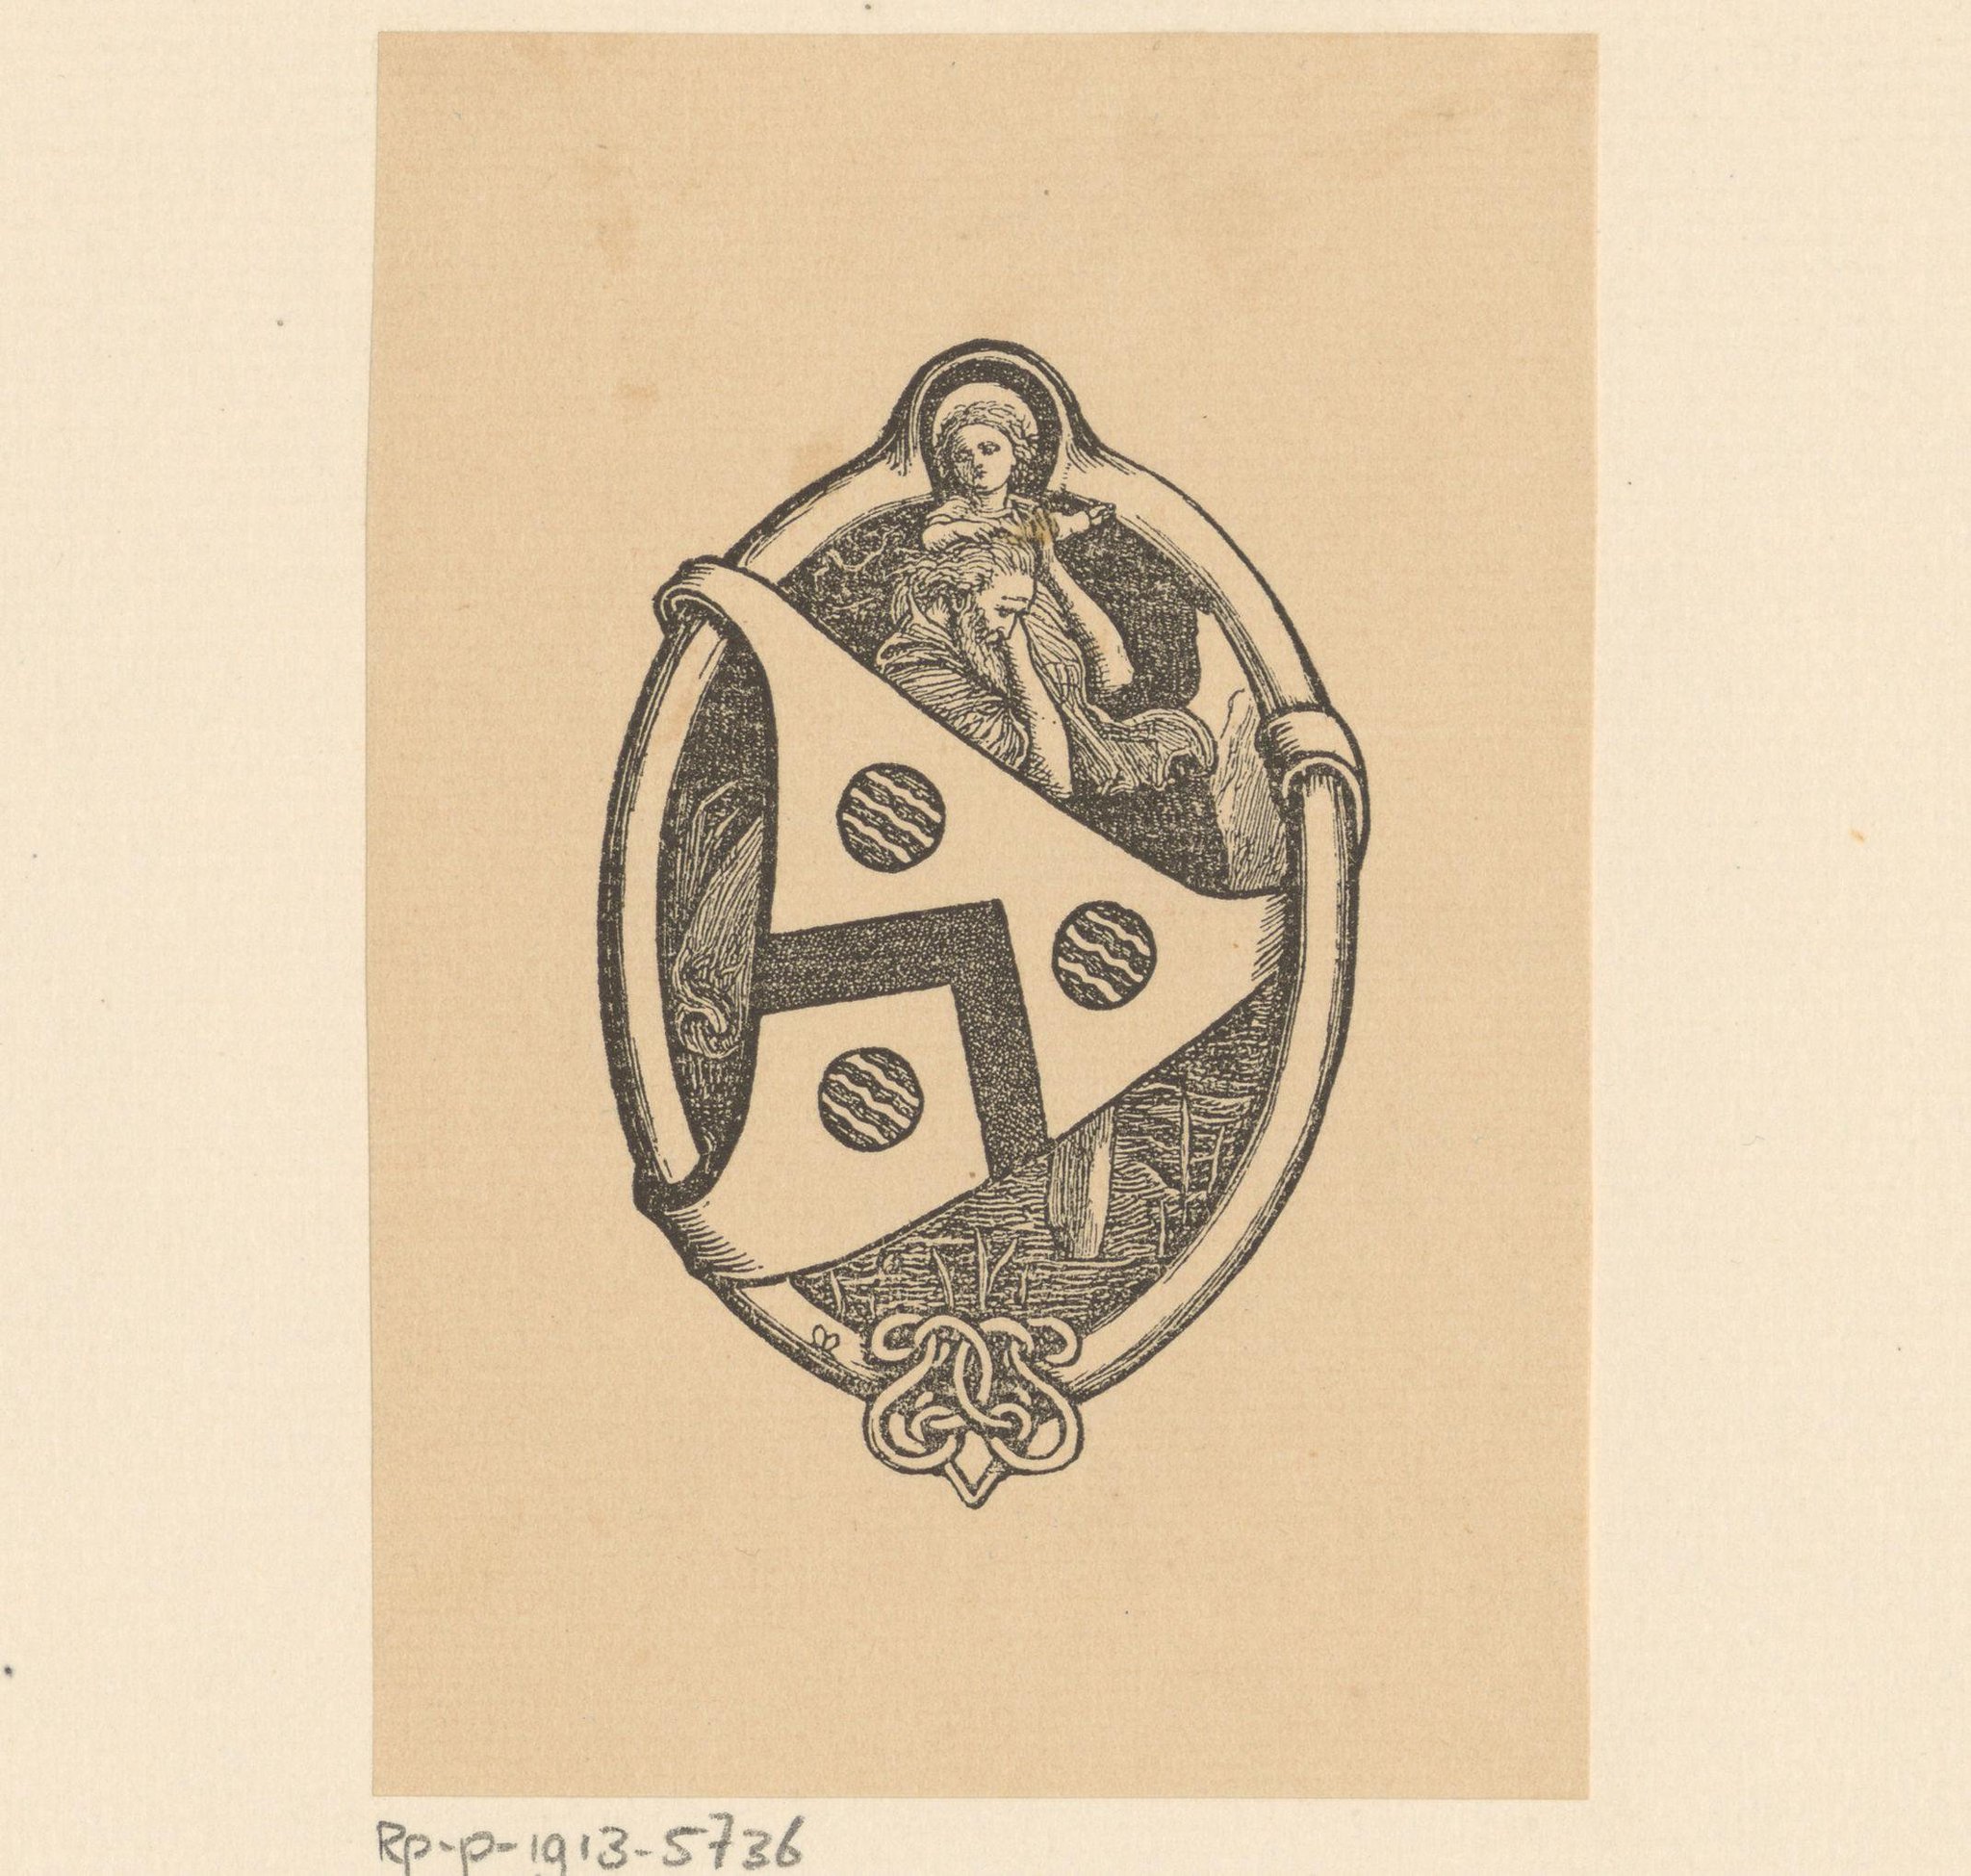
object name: bookplate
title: Ex libris van onbekend, mogelijk Sir Christopher Sykes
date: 1841-1896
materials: paper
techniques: woodcut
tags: the giant and martyr christophorus; possible attributes: palm-tree (with bunches of dates, or withered), infant christ, armorial bearing, heraldry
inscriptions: collector's mark: Lugt 2233, collector's mark: Lugt 2760